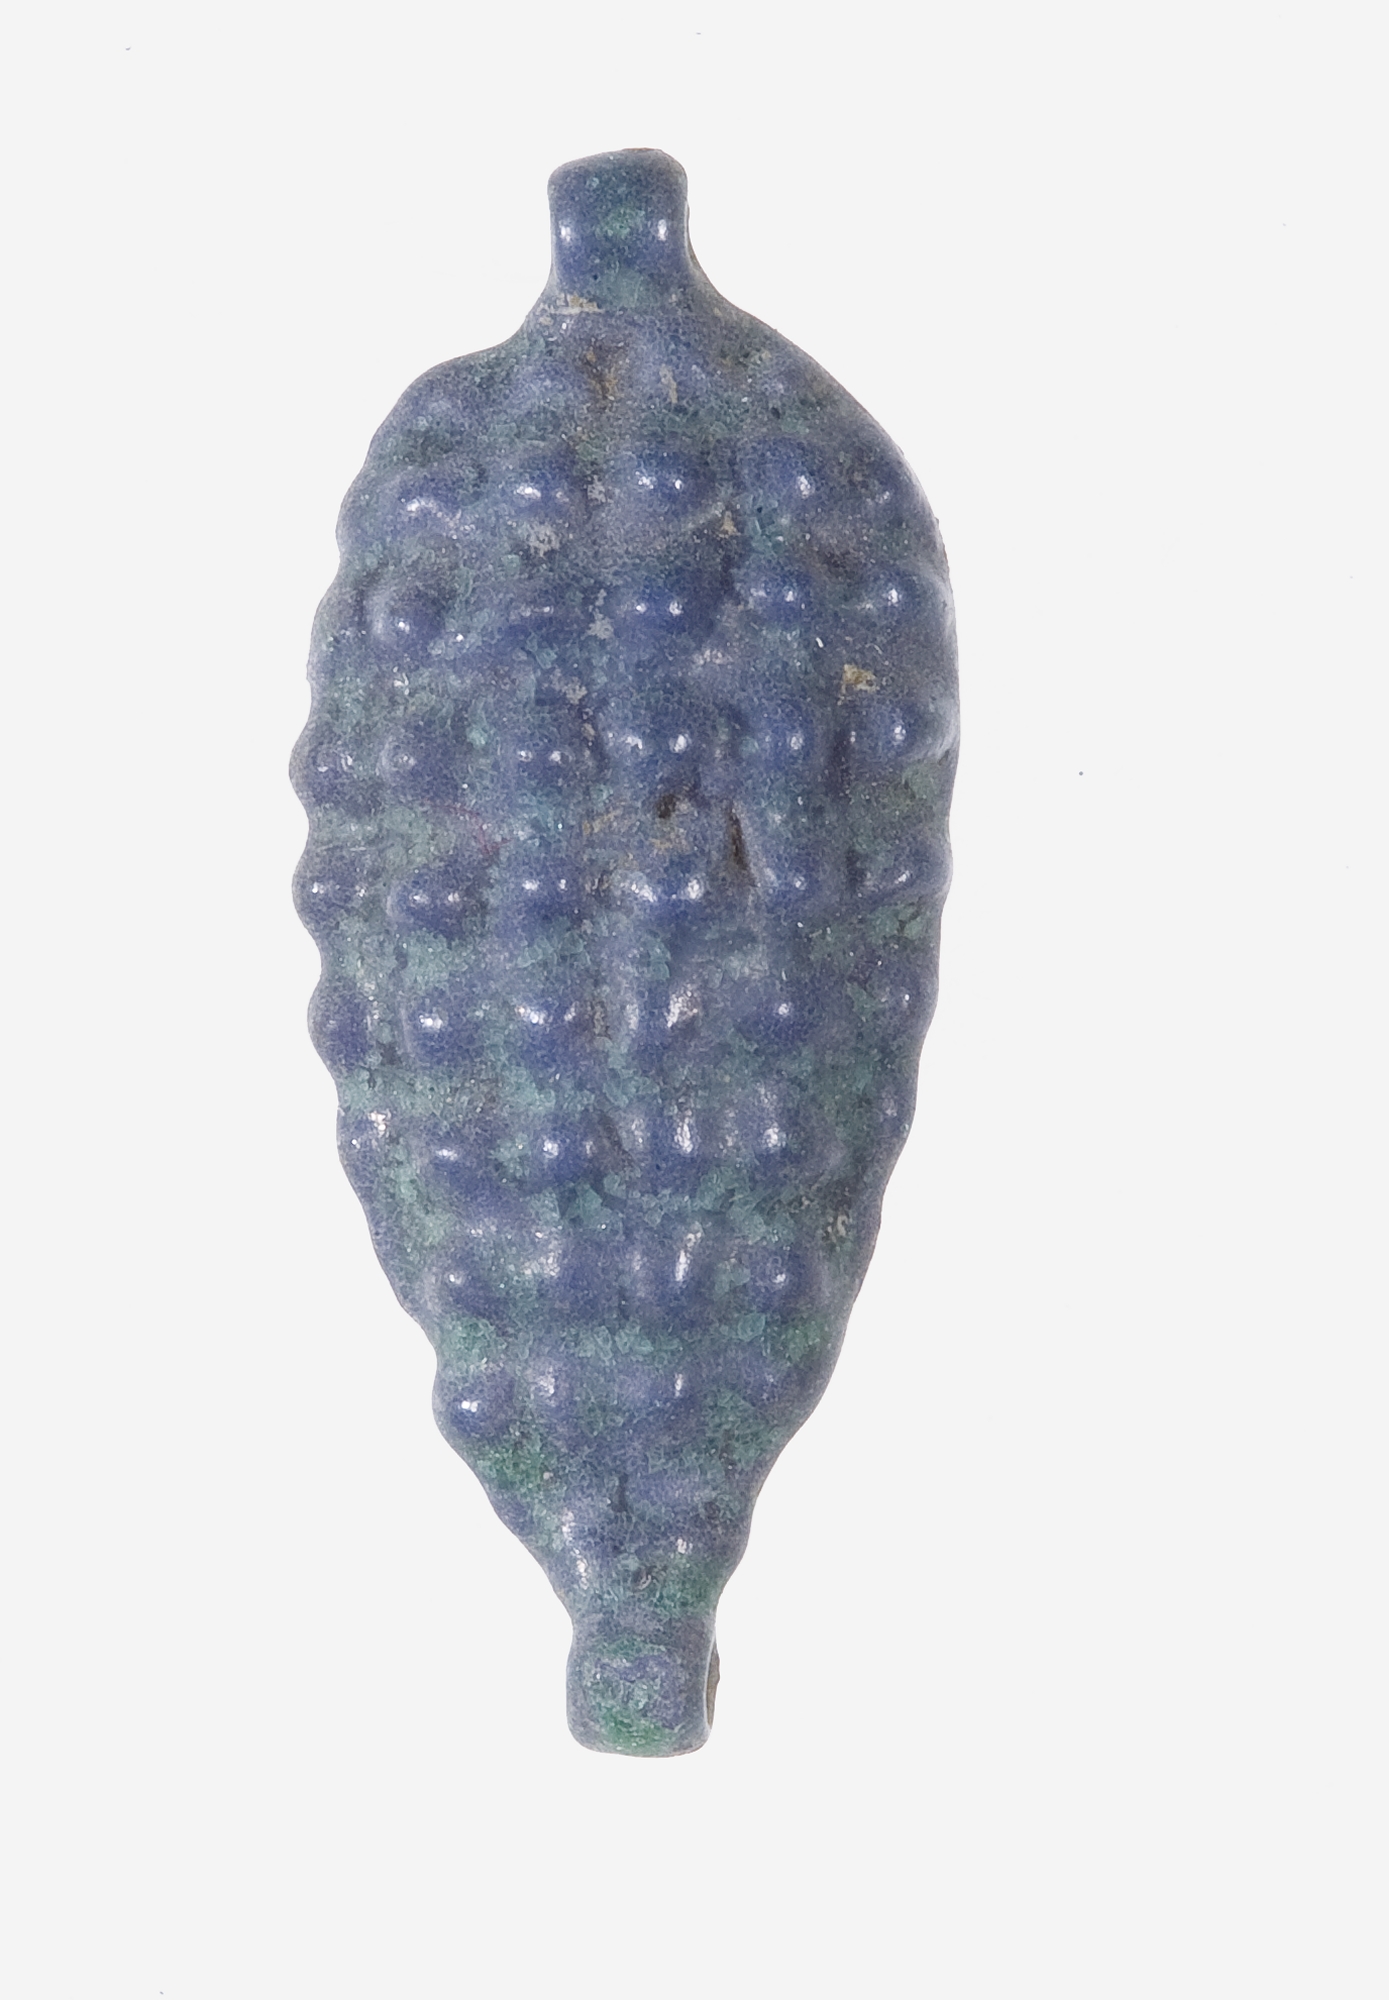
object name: bead, grape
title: Bead in the Form of a Bunch of Grapes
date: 1390-1352 BCE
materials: faience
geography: egypt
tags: grapes